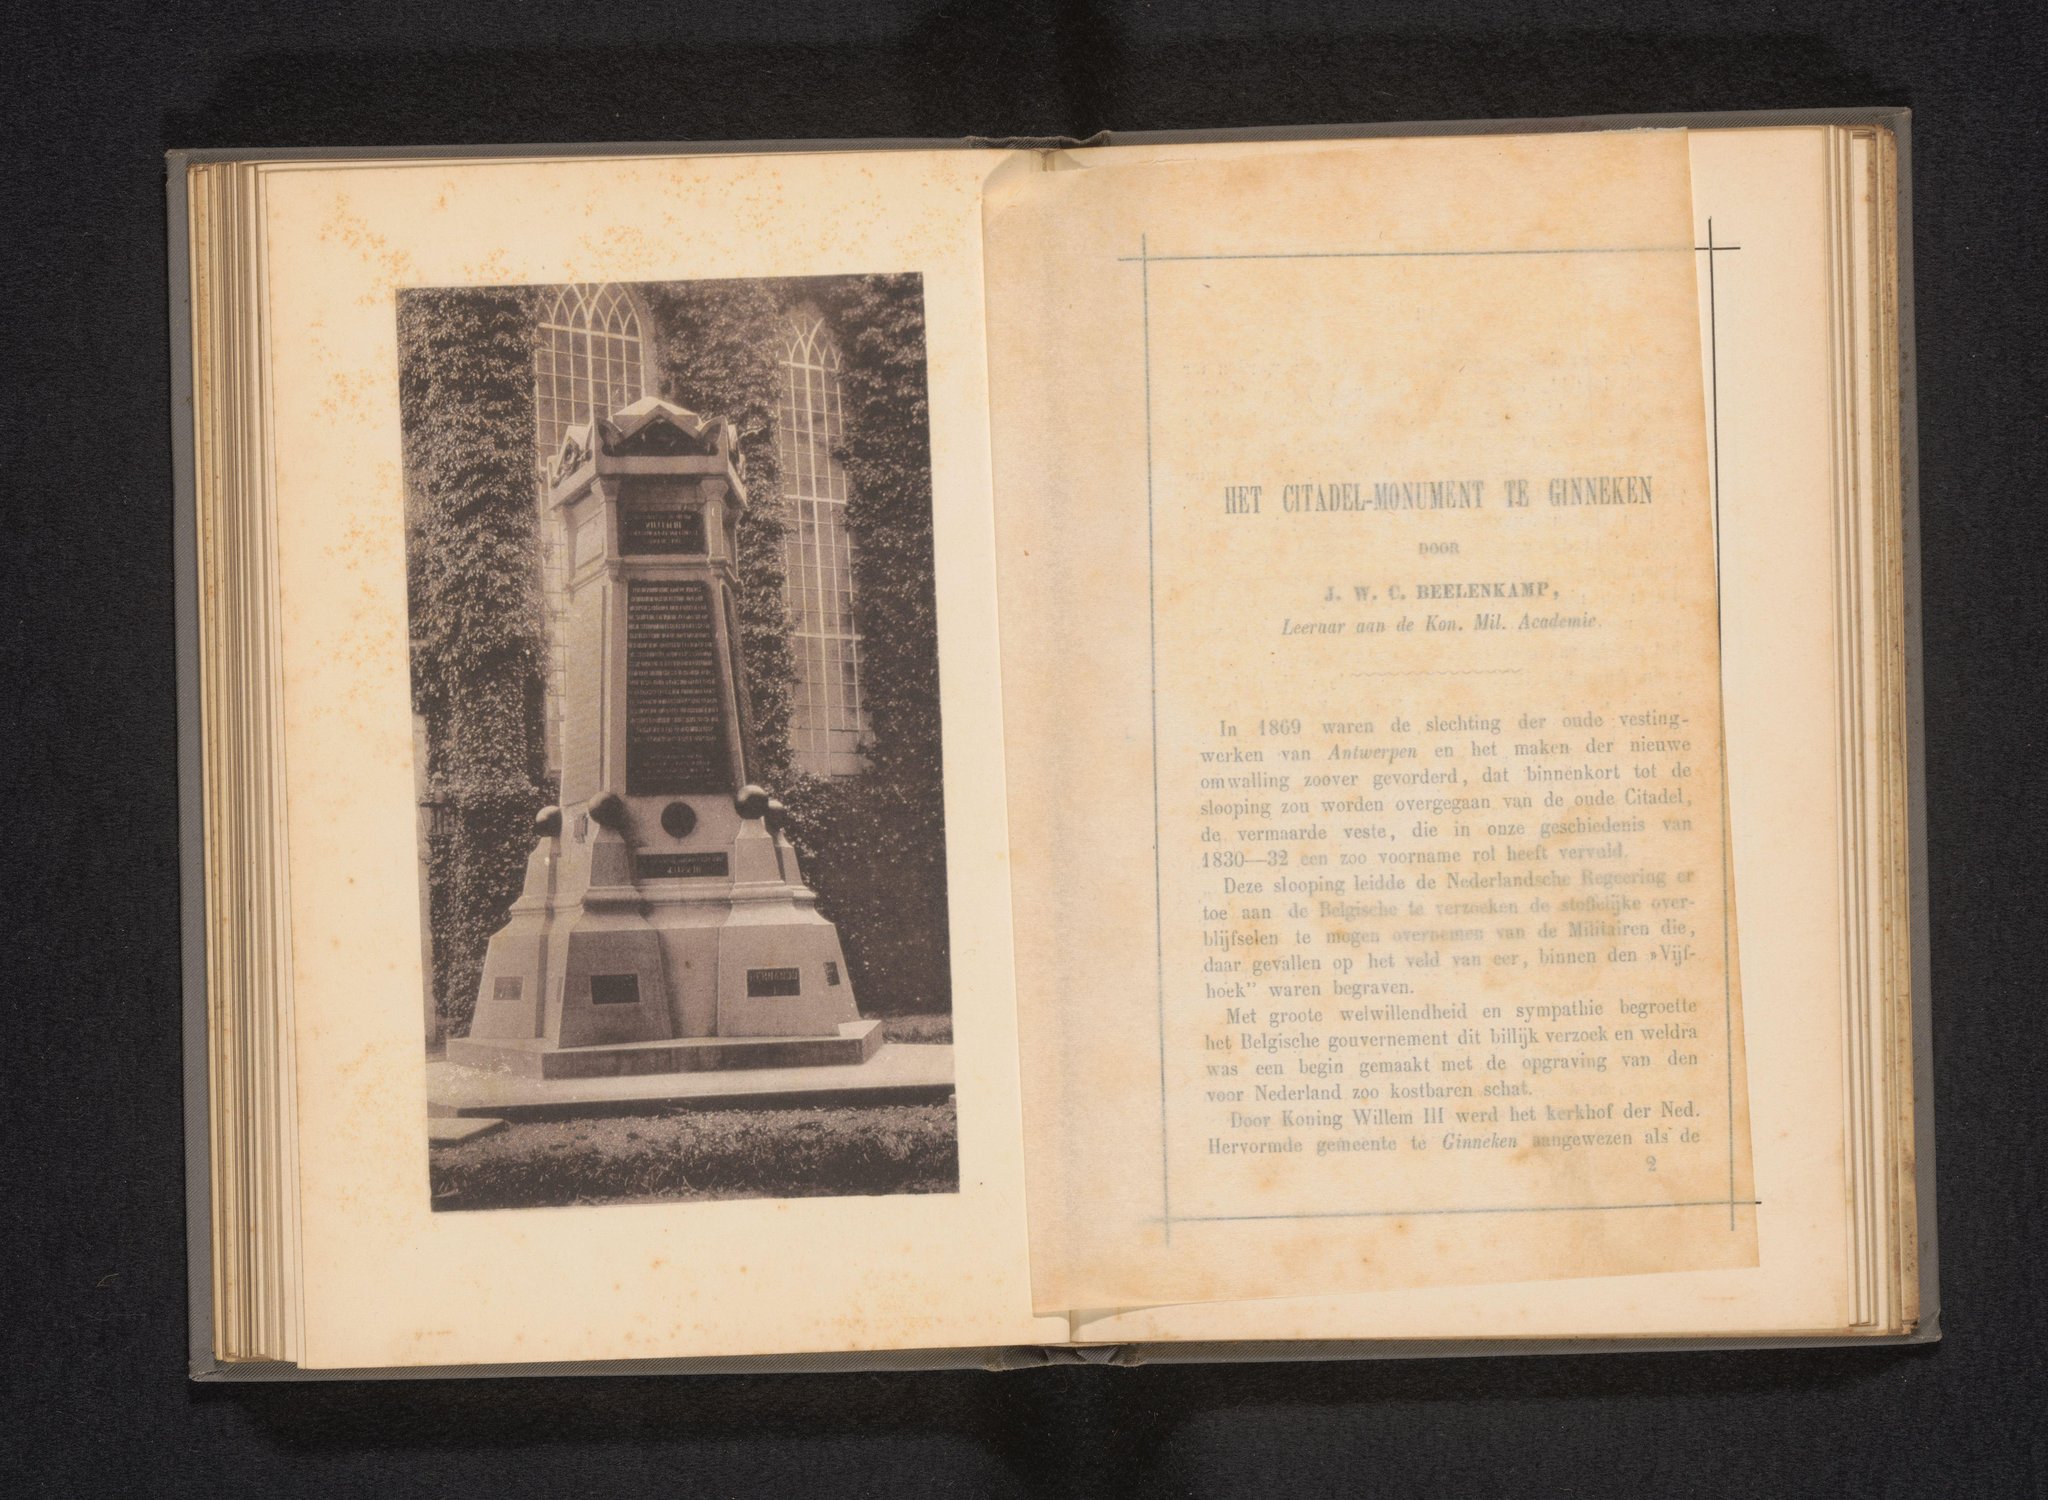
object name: photomechanical print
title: Gezicht op het Citadel-monument te Ginneken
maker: Anonymous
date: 1896-1901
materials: paper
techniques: photograph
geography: ginneken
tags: monument, statue